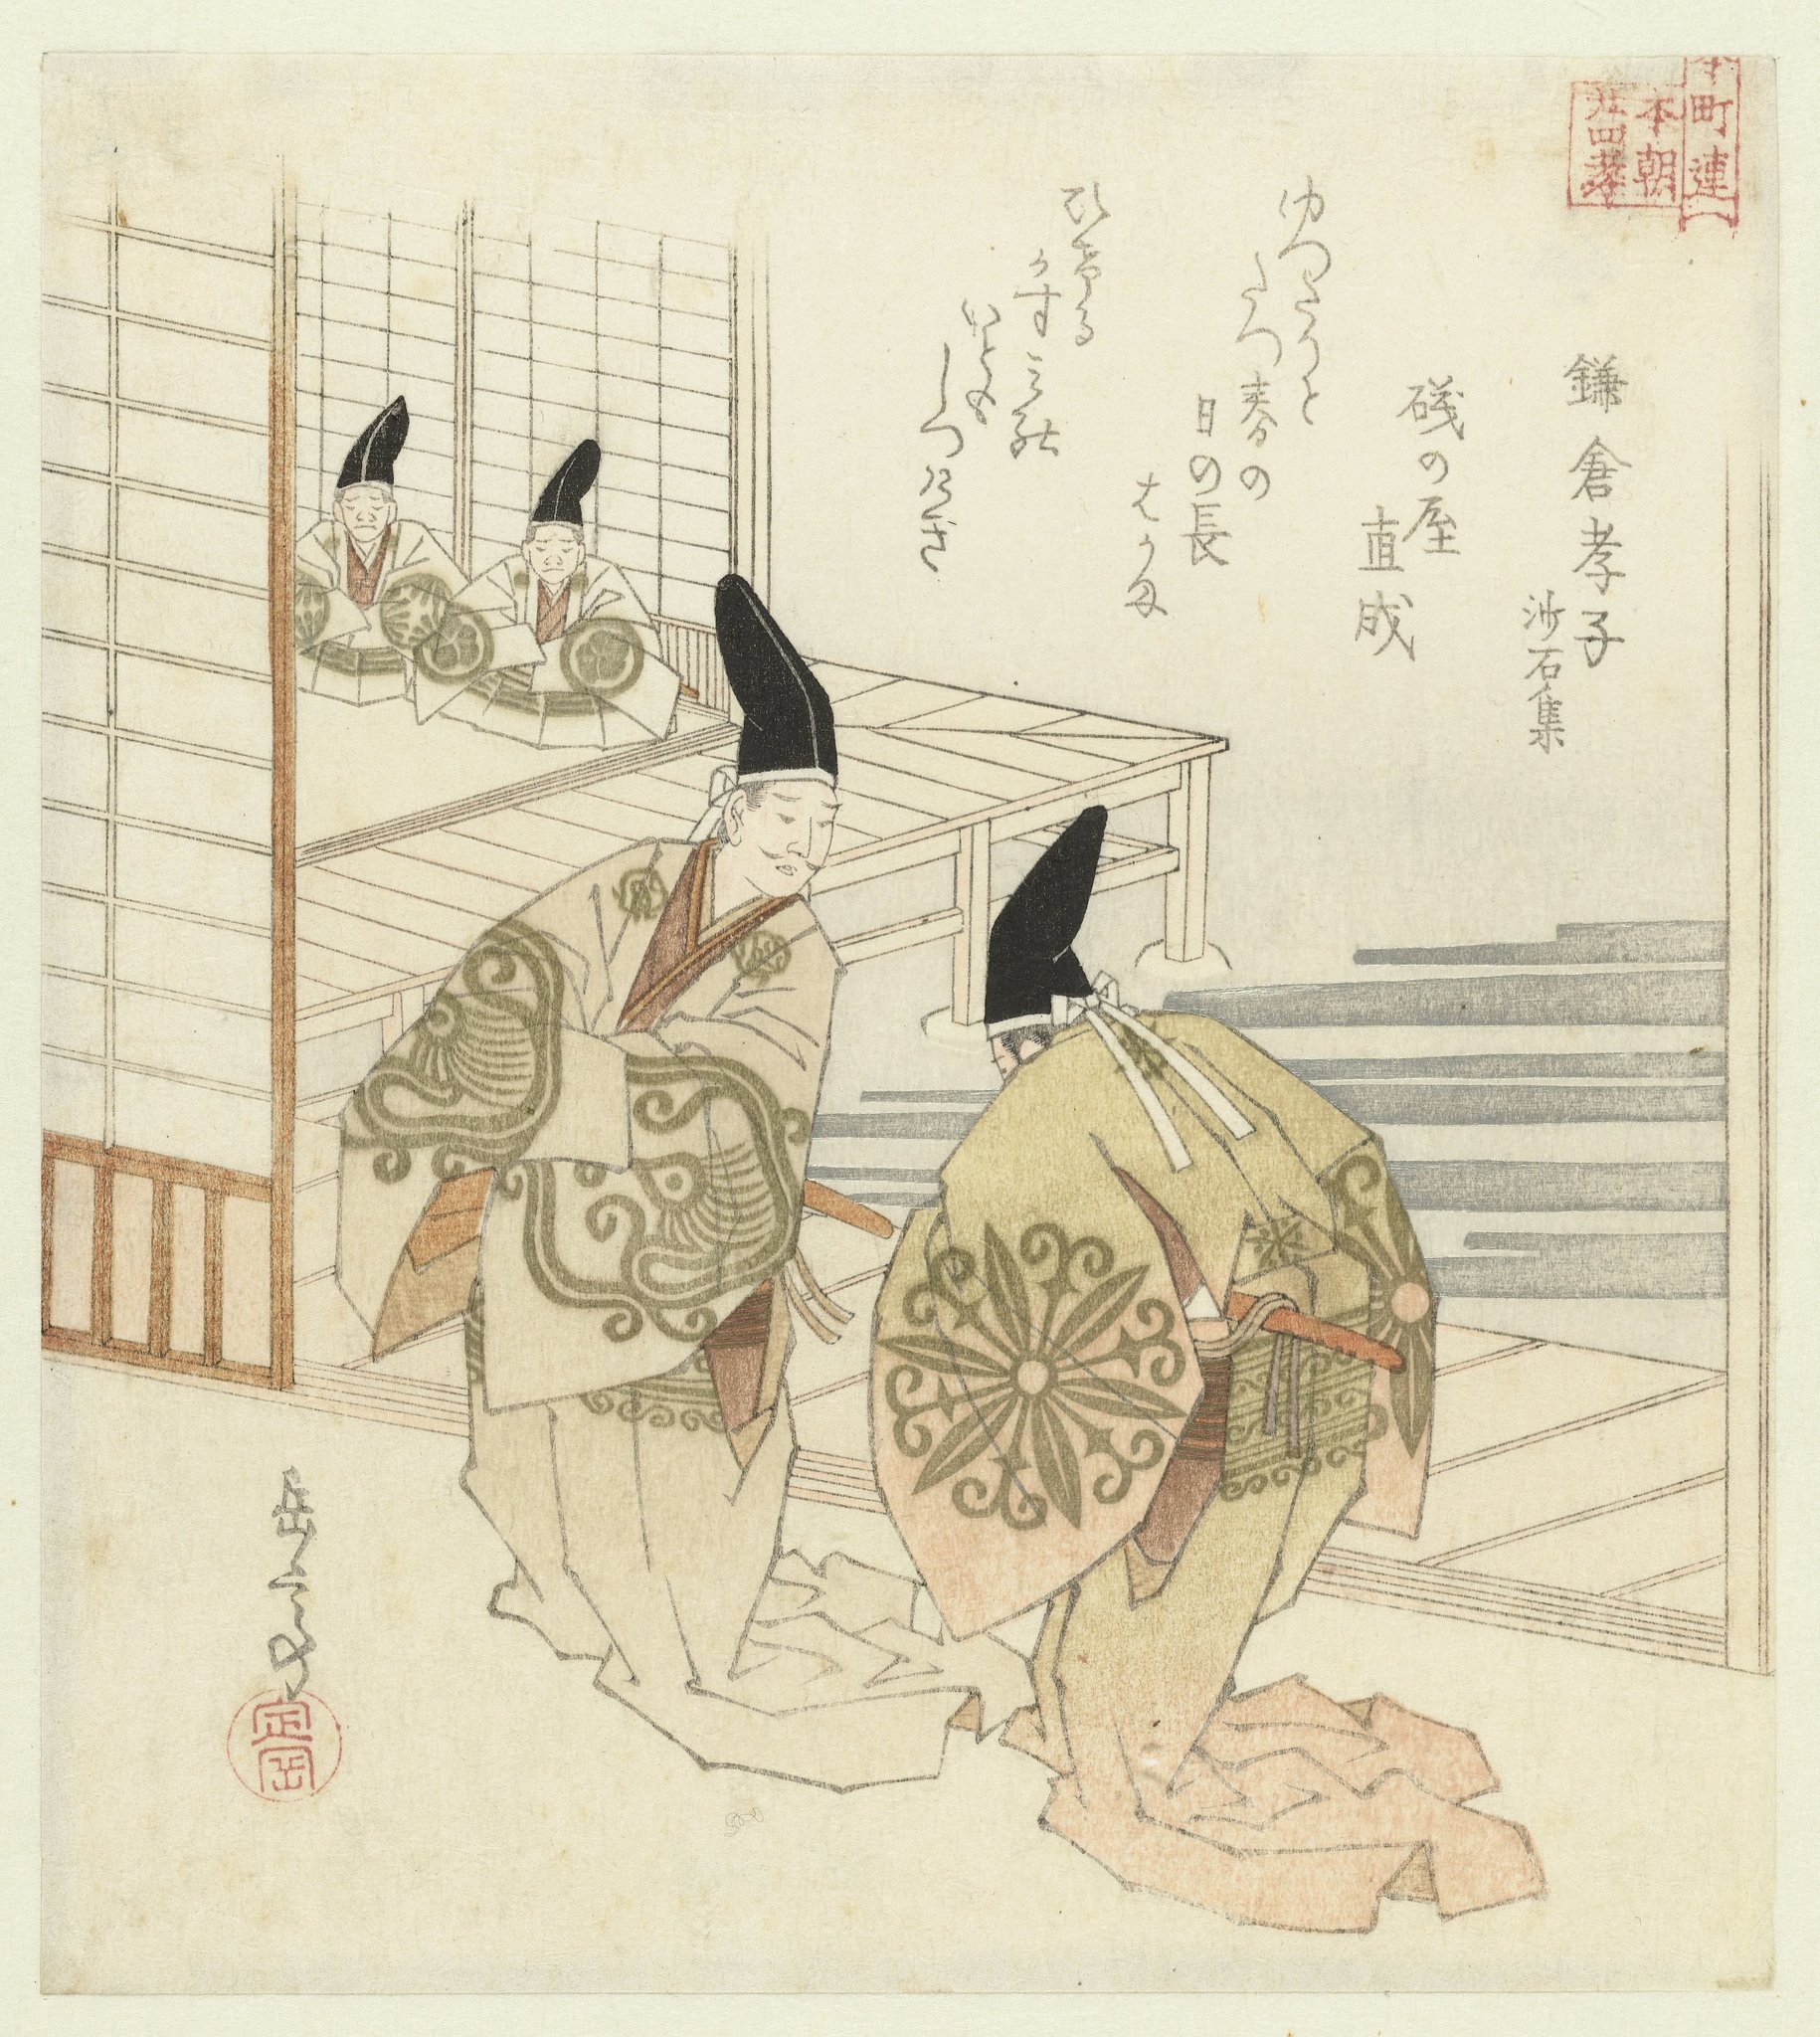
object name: surimono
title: Twenty-four Japanese examples of filial piety for the Honchôren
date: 1821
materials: paper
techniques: woodcut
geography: japan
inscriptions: collector's mark, passe-partout, bottom left, printed: JABdH with a rooster., collector's mark, verso, stamped: Lugt 2228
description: Een surimono is een luxe uitgevoerde prent waarop beeld met één of meerdere gedichten gecombineerd is. Bij het drukken van een surimono werd vaak gebruik gemaakt van dikker papier, blinddruk en metaal pigmenten, zoals koper- en zilverpoeder. De prenten werden vaak in opdracht van dichters gemaakt en als exclusief geschenk aan vrienden en relaties gegeven.